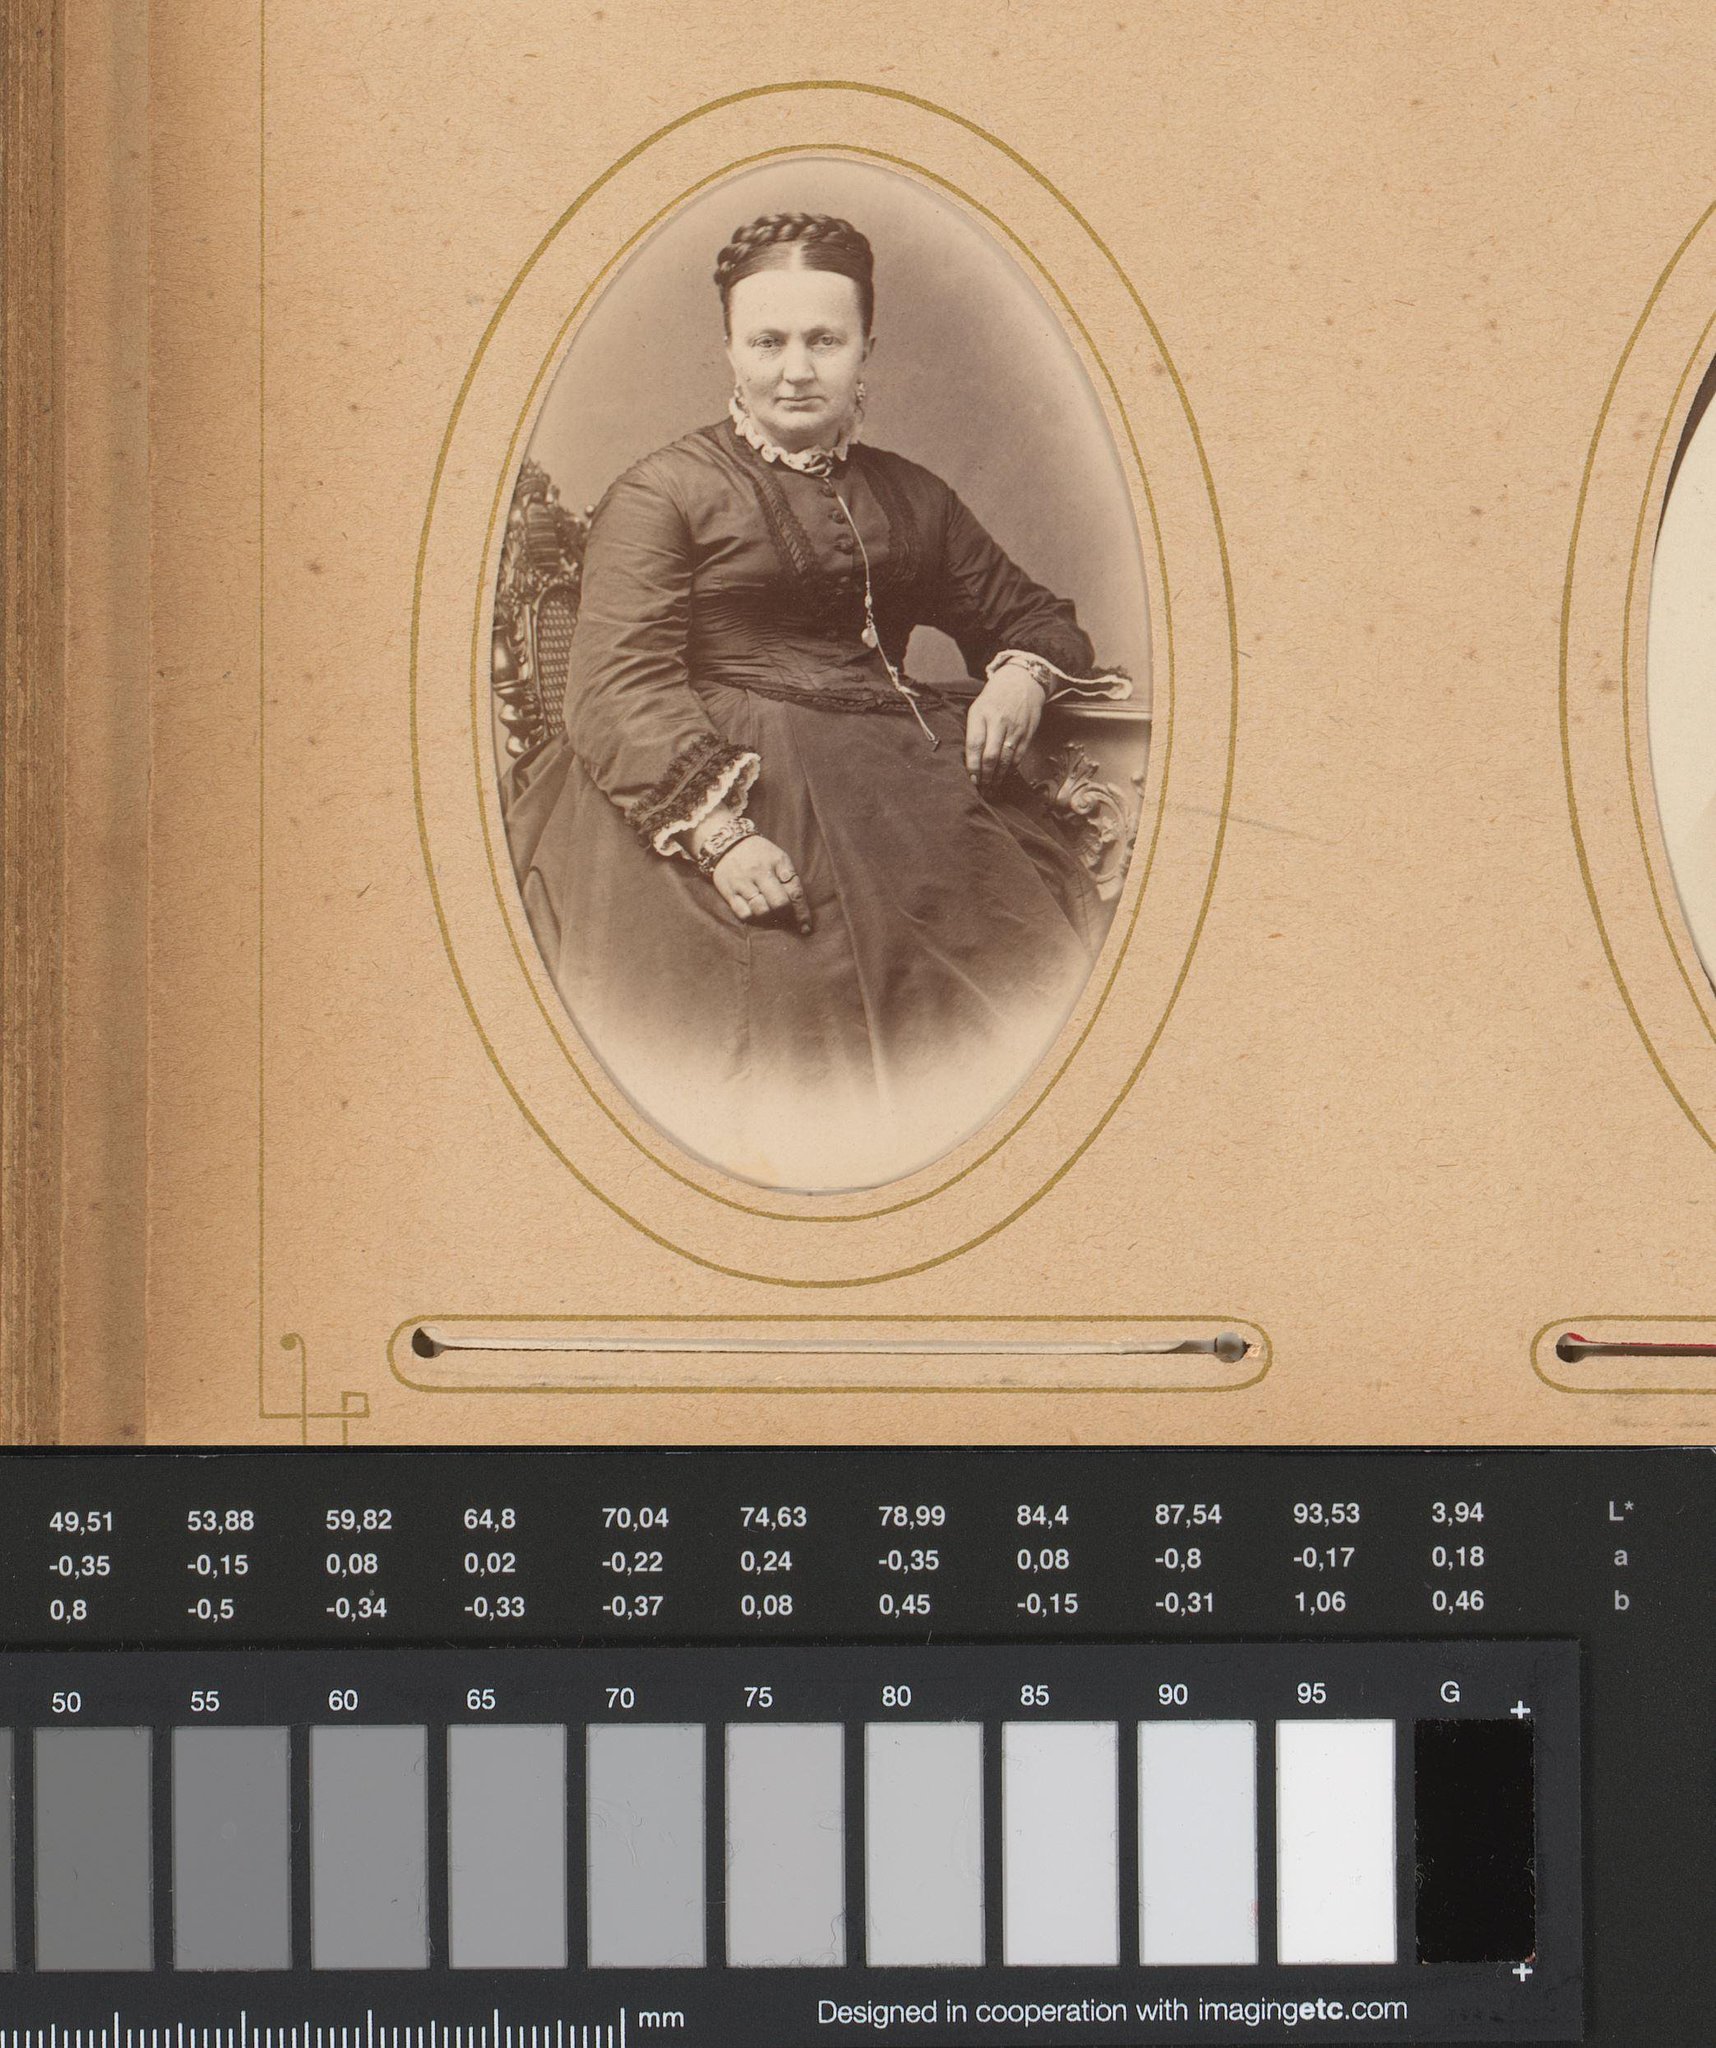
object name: album leaf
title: Portret van een vrouw, zittend aan een tafel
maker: Anonymous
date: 1860-1900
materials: cardboard, photographic support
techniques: albumen print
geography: germany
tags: sitting figure - aa - female human figure, historical persons - bb - woman, table